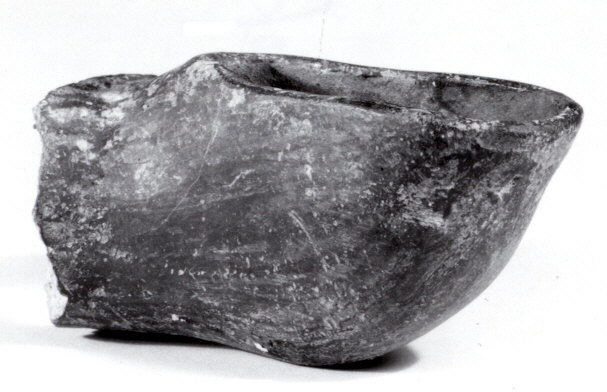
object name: cup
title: Piped cup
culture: assyrian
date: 1800-1701 BCE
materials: ceramic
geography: anatolia